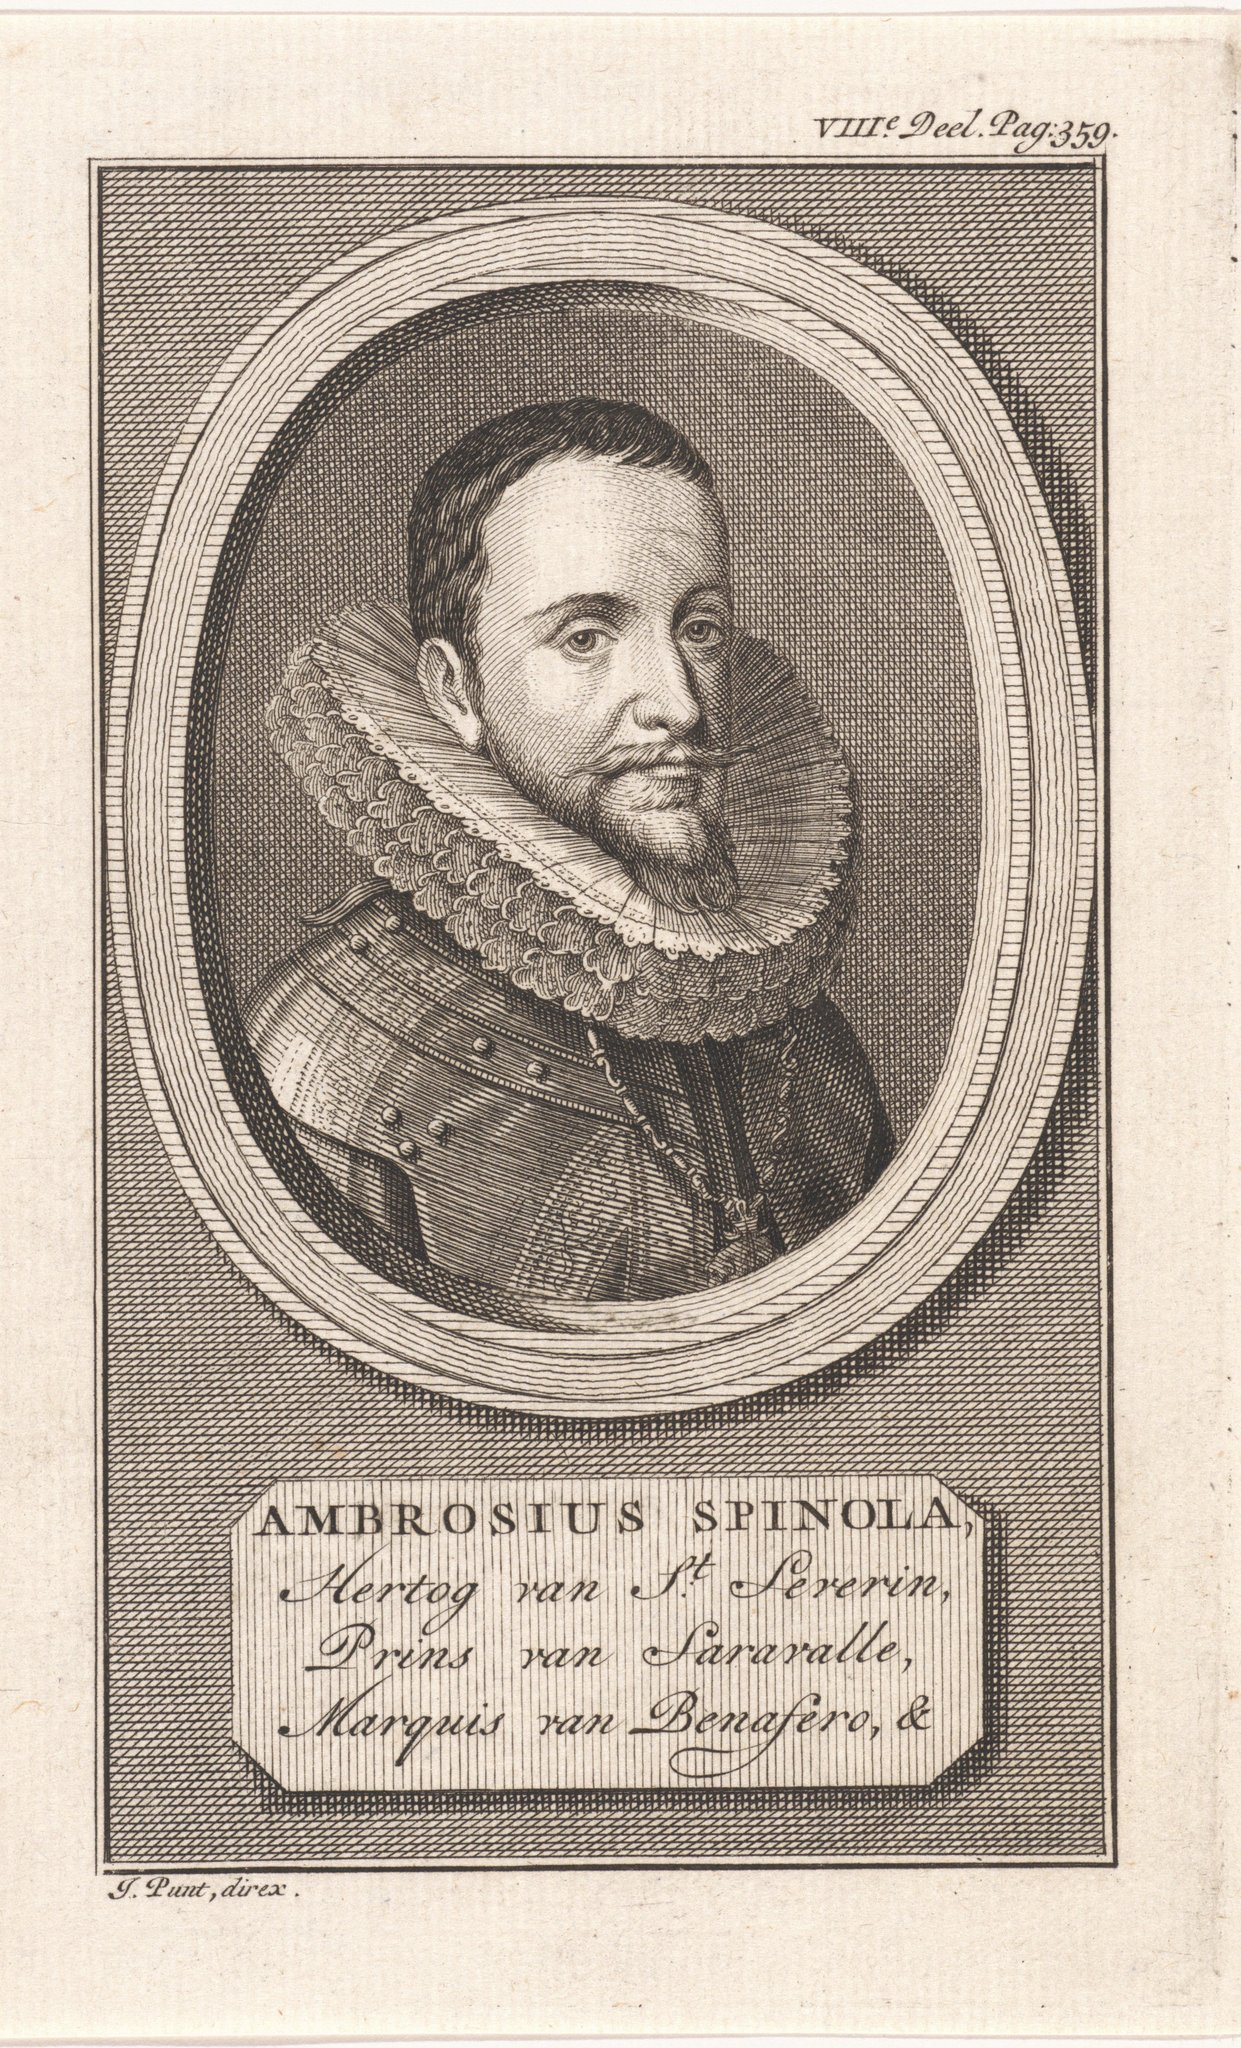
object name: print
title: Portret van Ambrogio Spinola, markies de los Balbases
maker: jan punt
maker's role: draughtsman, print maker, publisher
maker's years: 1711-1779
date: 1760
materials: paper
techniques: engraving, etching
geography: northern netherlands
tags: armour, knighthood order of the golden fleece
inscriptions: collector's mark: Lugt 2228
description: Illustratie uit: Meteren, Emanuel van. Historie van de oorlogen en geschiedenissen der Nederlanderen, en der zelver naburen: beginnende met den jare 1315, en eindigende met den jare 1611, deel VIII, p. 359. Gorinchem: weduwe Nicolaas Goetzee, 1760.